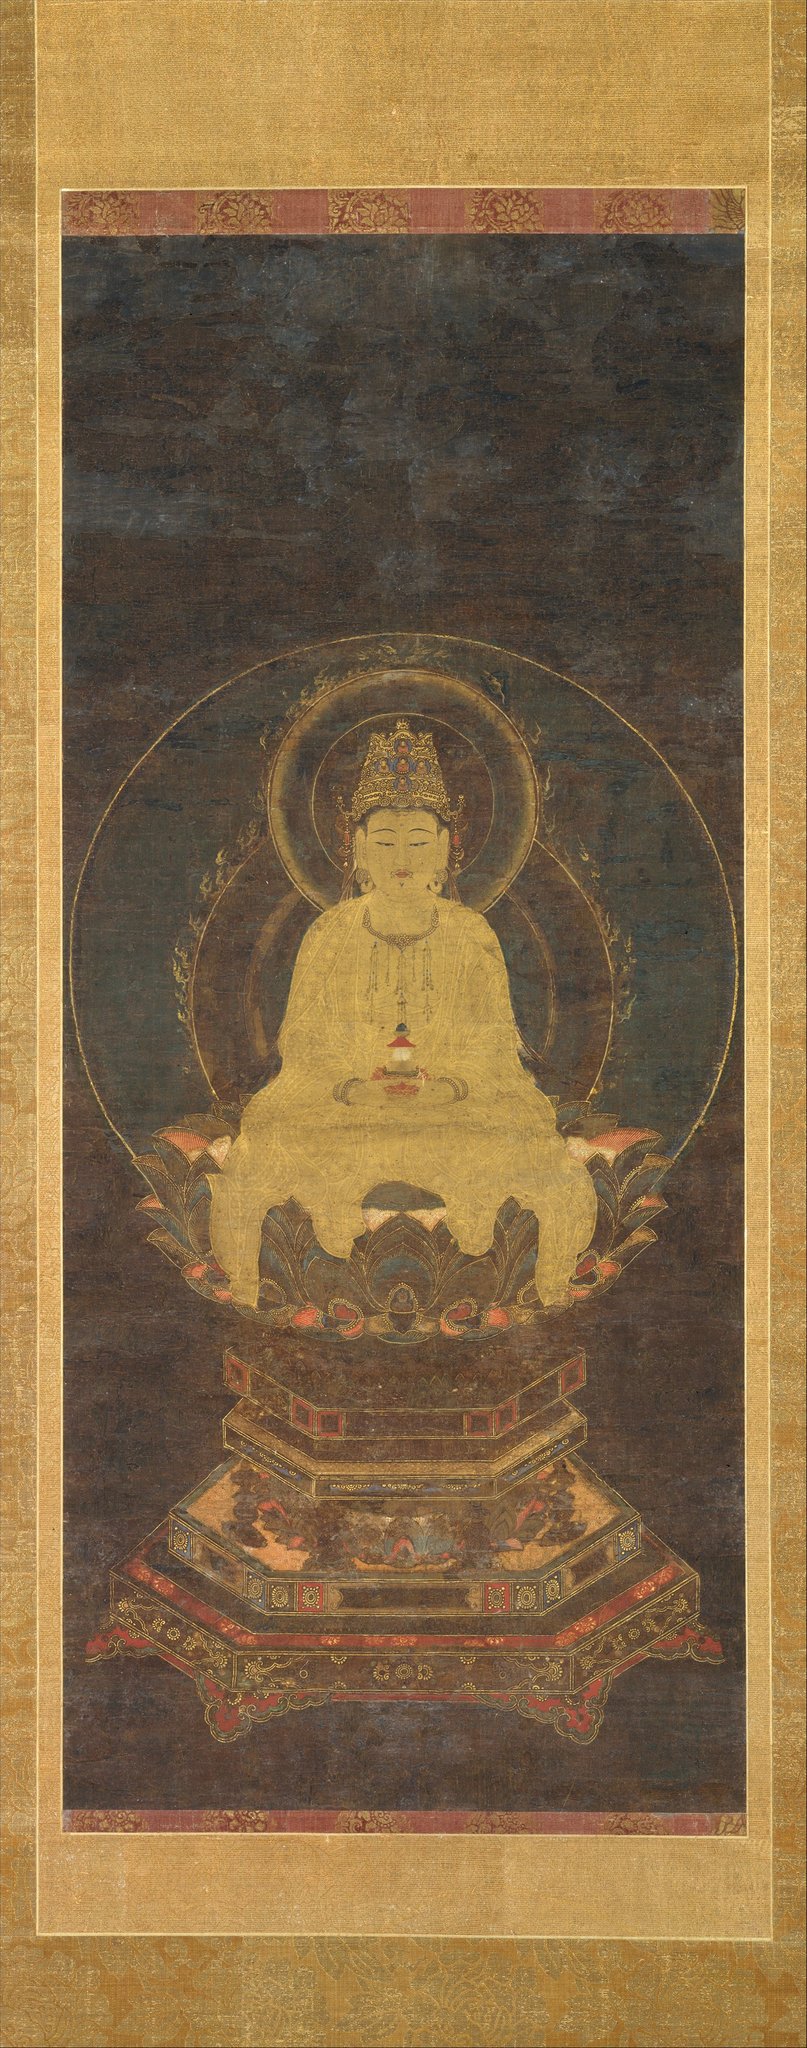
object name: hanging scroll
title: Miroku Bosatsu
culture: japanese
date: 1301-1400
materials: gold, ink, silk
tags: bodhisattvas,maitreya